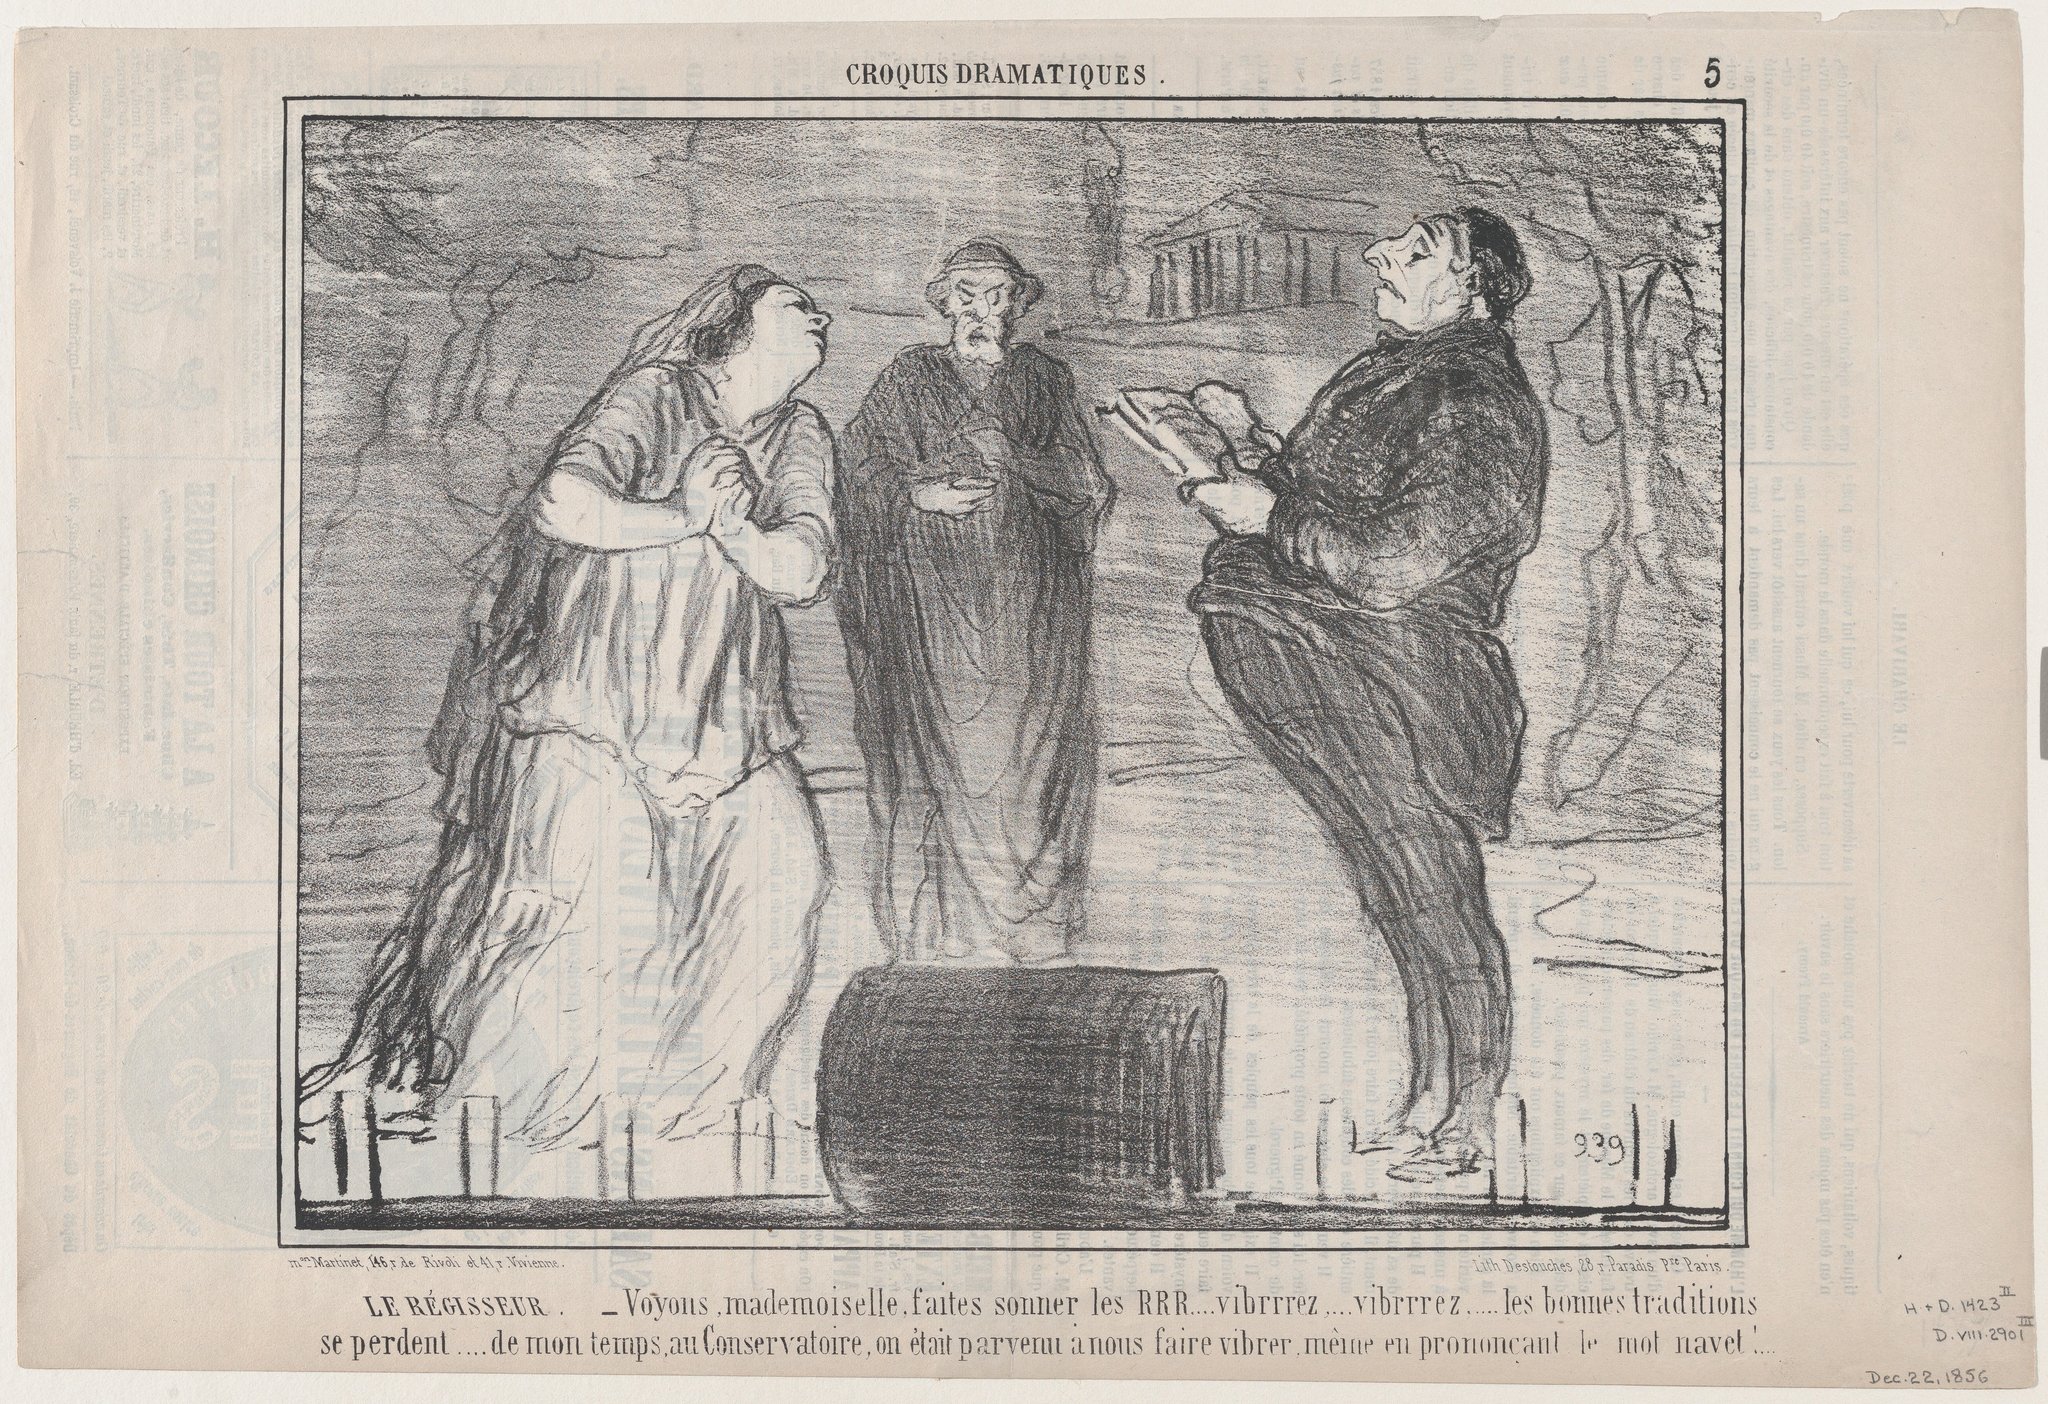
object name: print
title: Le Régisseur. – Voyons mademoiselle, faites sonner..., from "Croquis Dramatiques"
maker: honoré daumier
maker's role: artist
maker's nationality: french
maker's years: 1808-1879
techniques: lithograph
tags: men,women